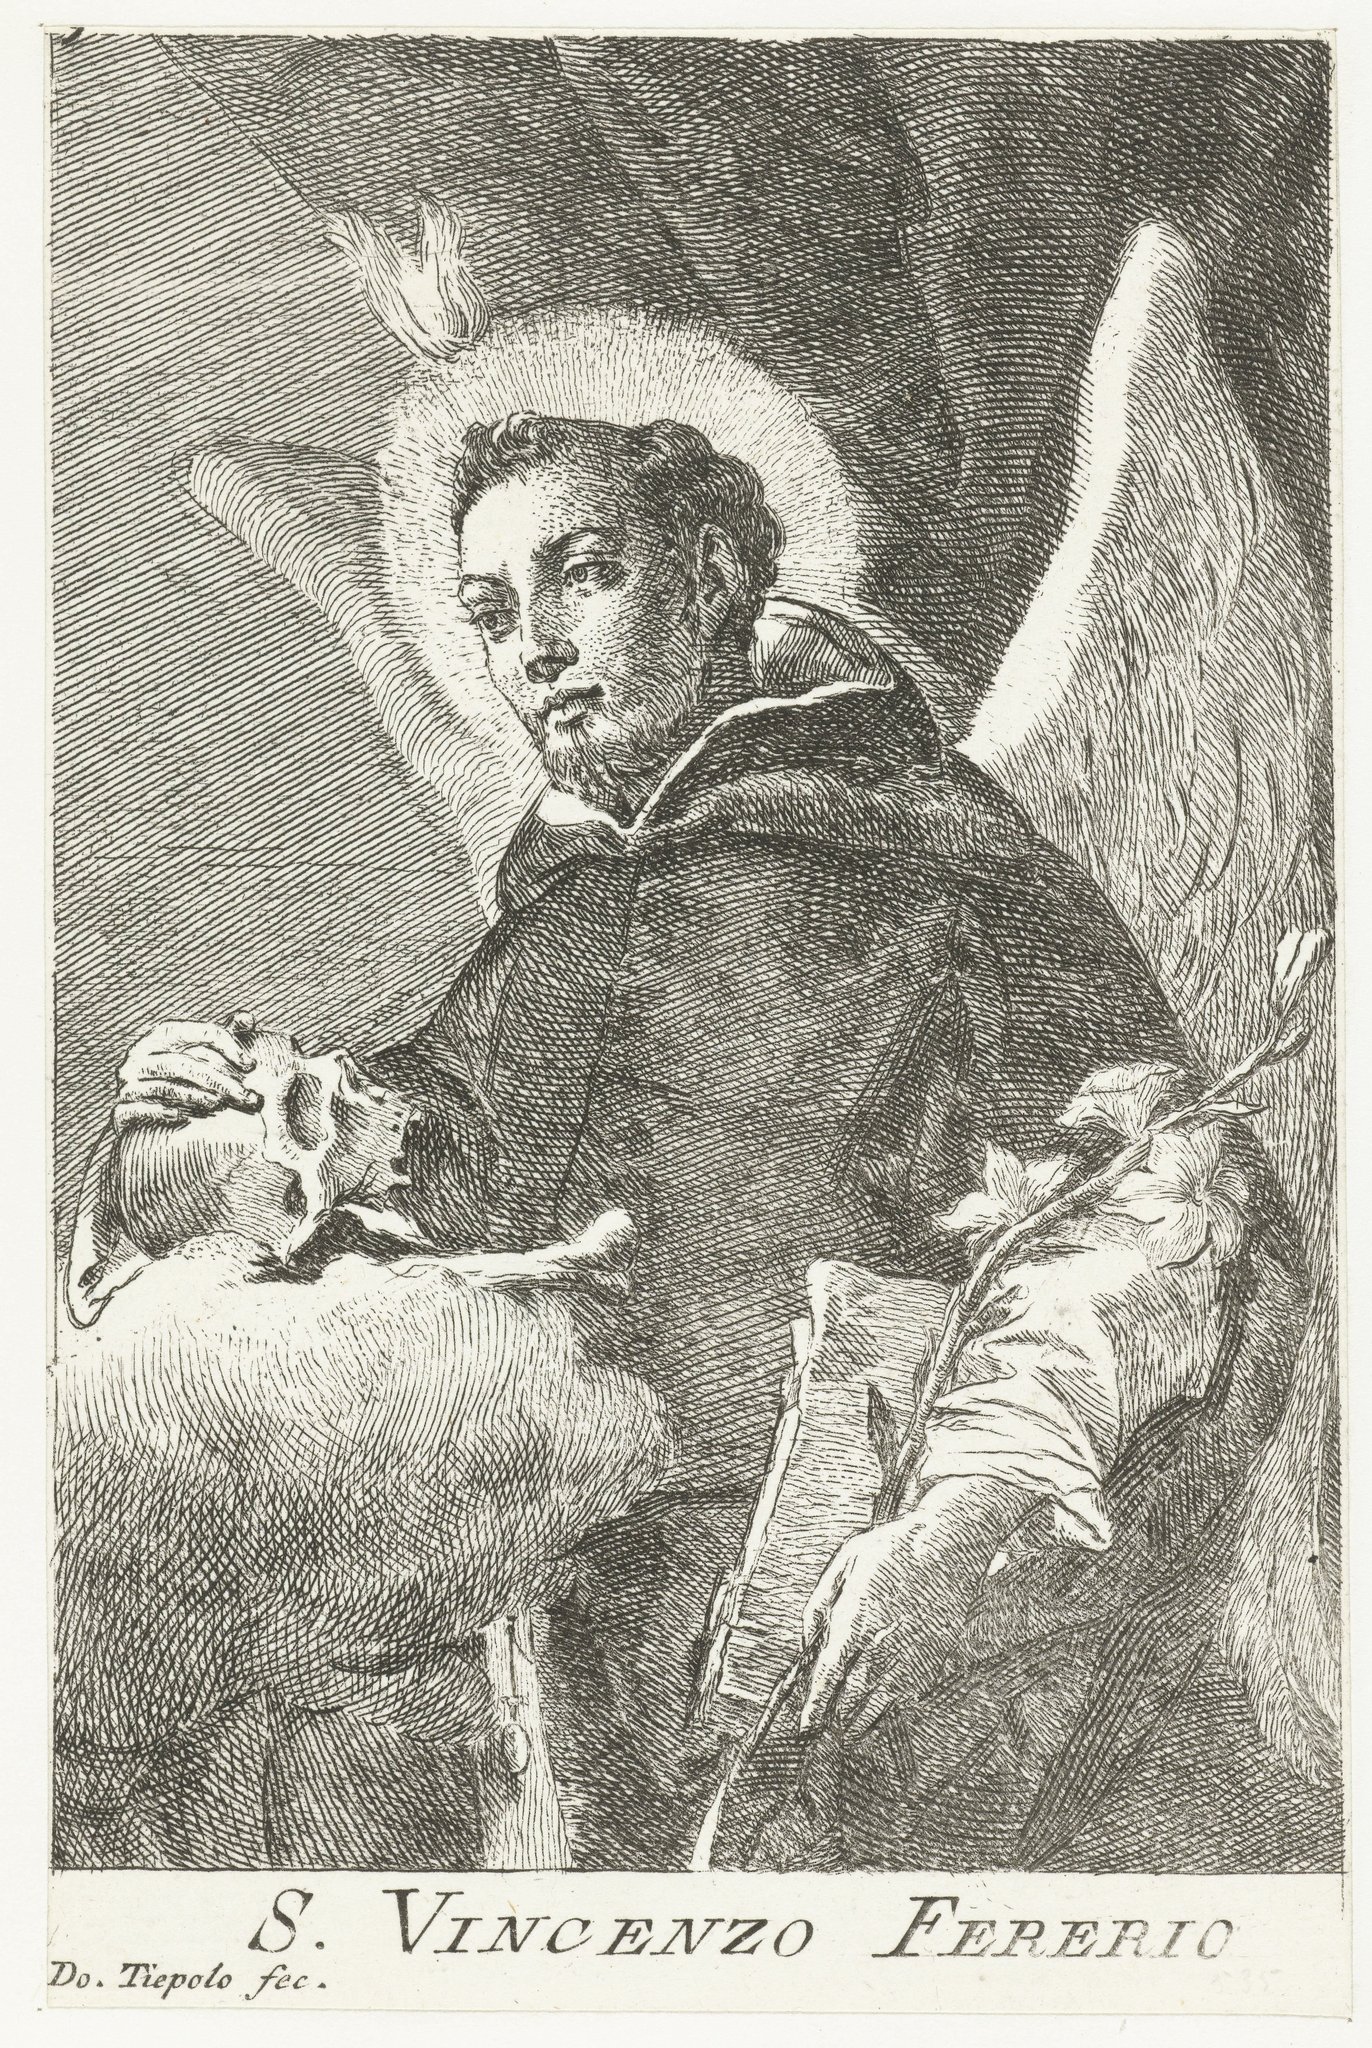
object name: print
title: Heilige Vincentius Ferrer (Ferrier) met vleugels en schedel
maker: giovanni domenico tiepolo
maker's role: draughtsman, print maker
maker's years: 1727-1804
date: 1740-1744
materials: paper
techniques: etching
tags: the dominican friar vincent ferrer of valencia (or vannes); possible attributes: book, baptismal font, cardinal's hat at feet, flames, flaming sword, ihs monogram, lily, sun, trumpet of the last judgement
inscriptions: collector's mark: Lugt 2760, collector's mark: Lugt 2228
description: Linksboven is nog net een staart van het cijfer 9 zichtbaar wat duidt op de tweede staat van deze prent.